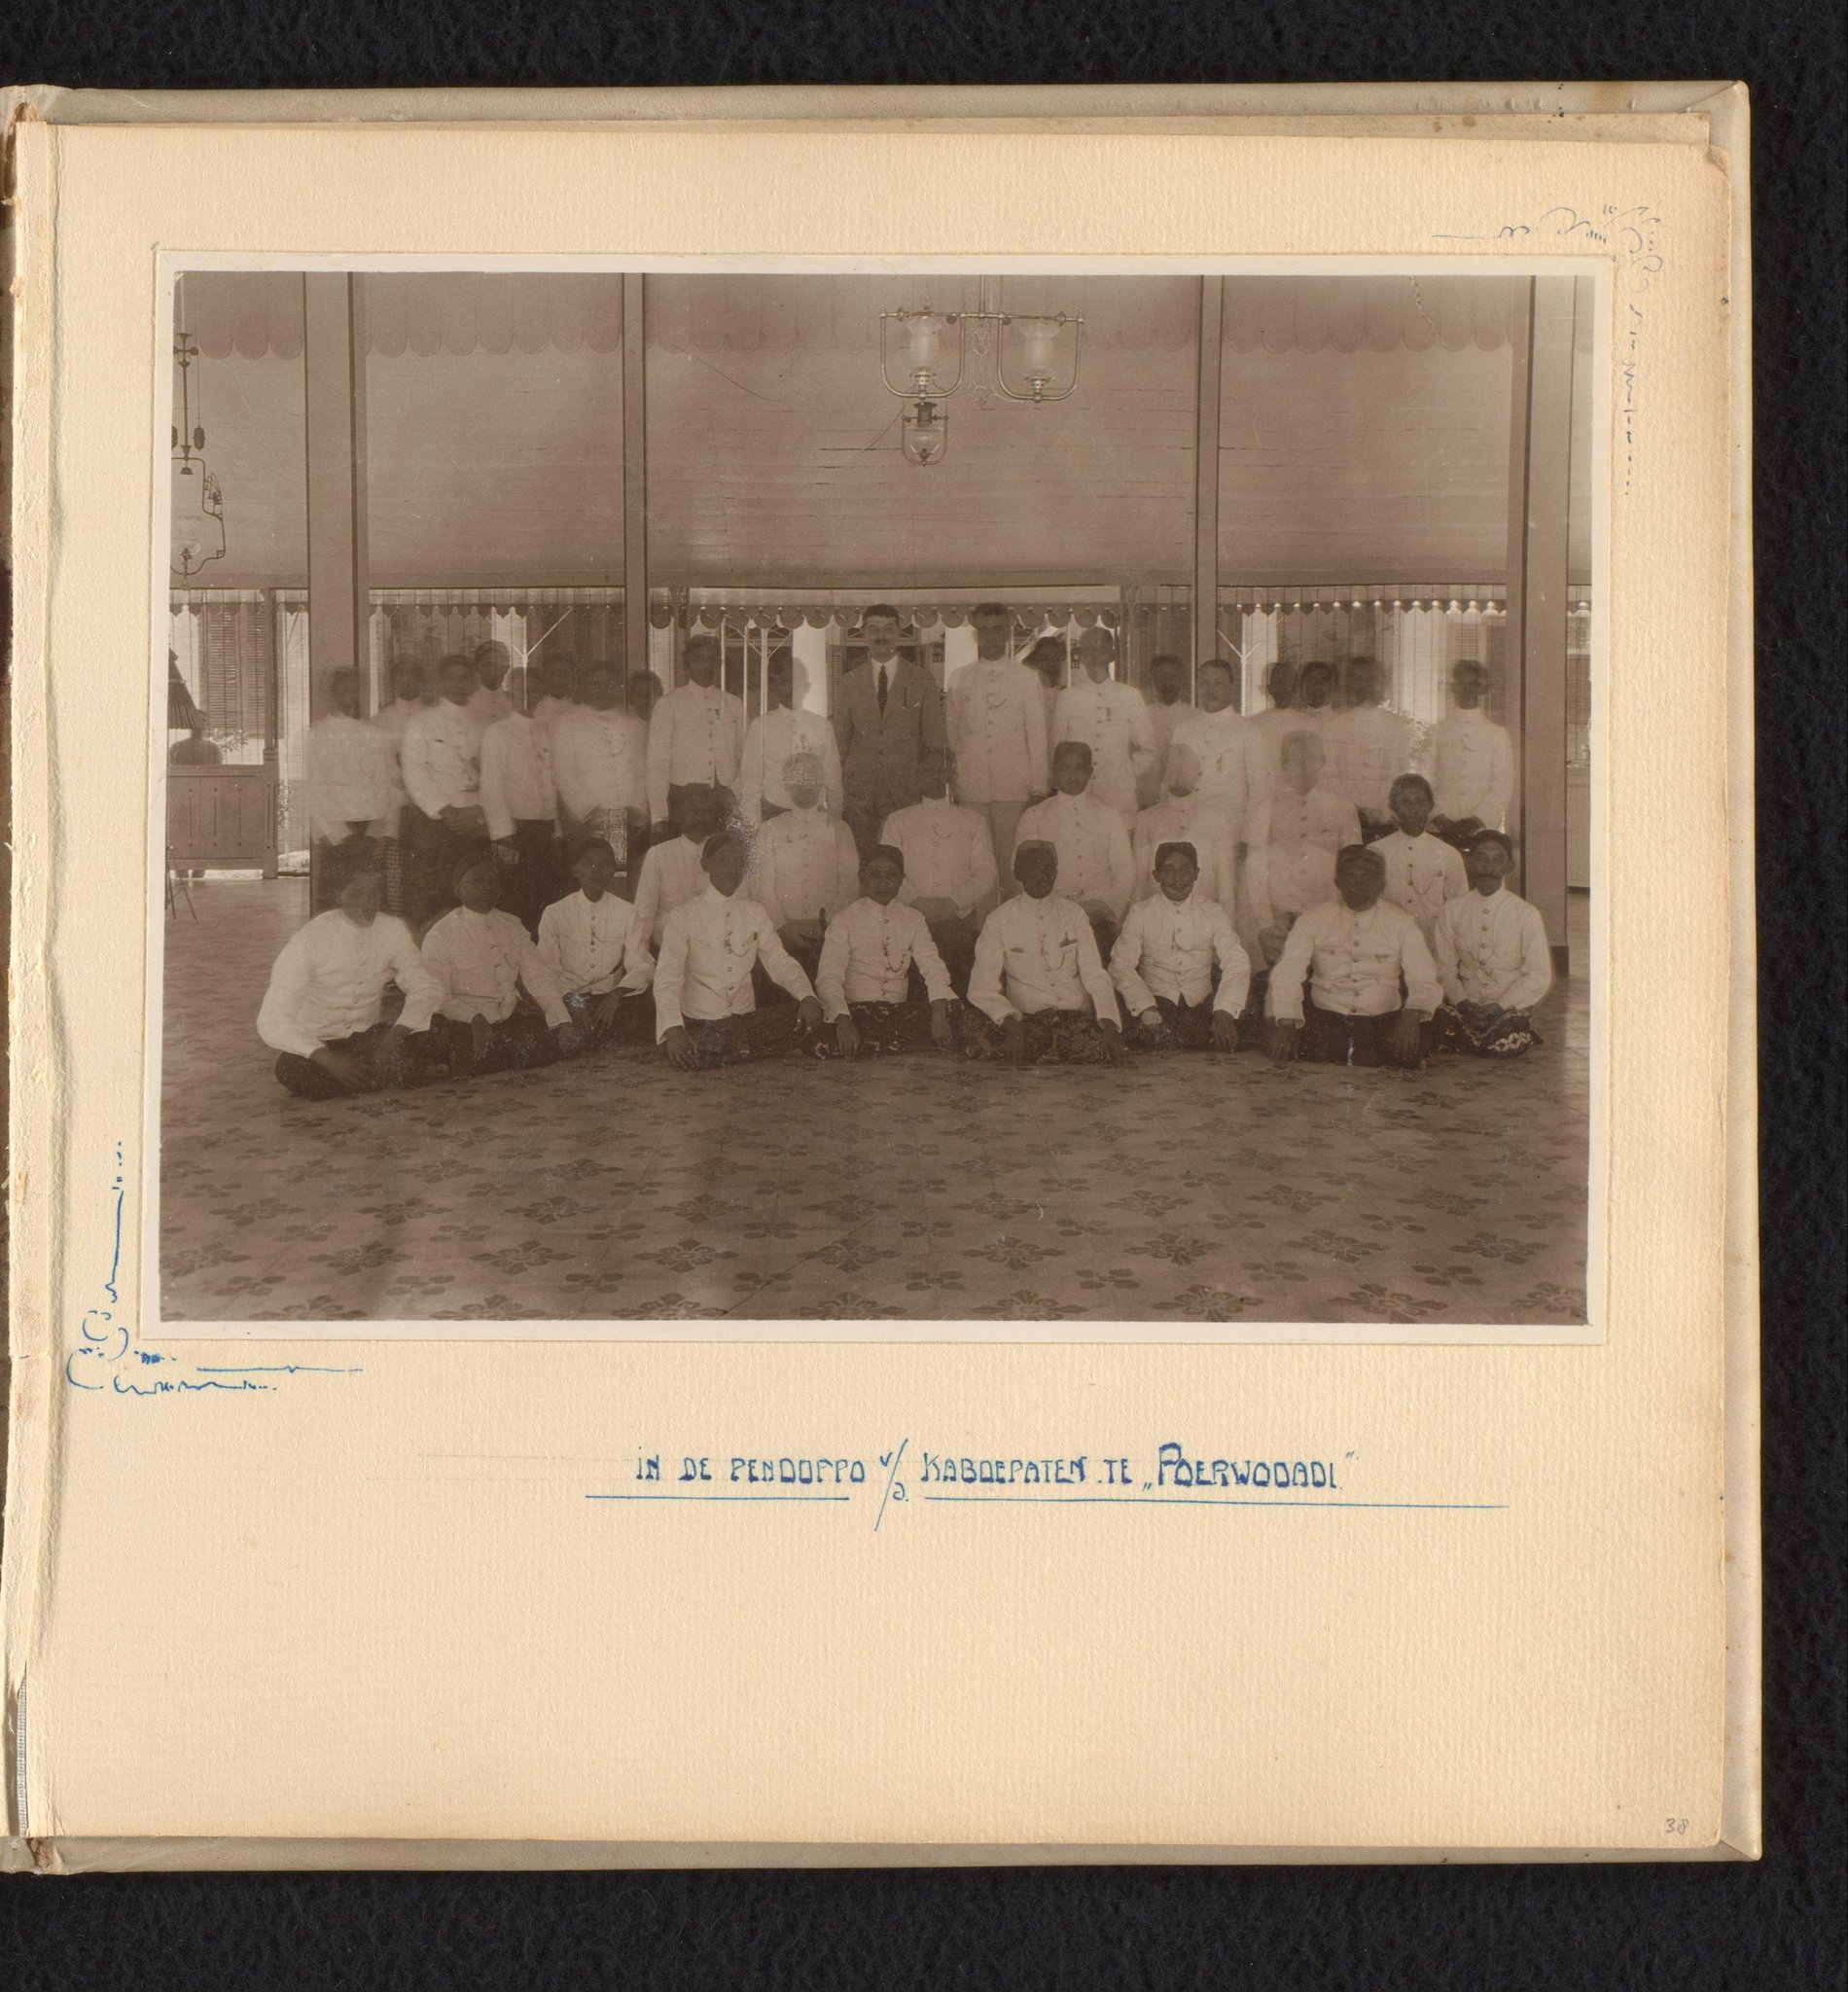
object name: photograph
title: Groepsfoto in een pendopo in Purwodadi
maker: Anonymous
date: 1910-1928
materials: paper, photographic support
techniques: drawing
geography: grobogan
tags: colonial government, anonymous historical persons portrayed in a group, in a group-portrait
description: Albumblad met een groepsfoto met Habbema in de pendopo van Purwodadi in Grobogan. Het blad is versierd met randwerk om de foto's. Onderdeel van het fotoalbum aangeboden aan J. Habbema door het Binnenlandsch Bestuur Corps van het Regentschap Grobogan, bij het beëindigen van zijn bestuur over het Regentschap, waarschijnlijk in 1928.